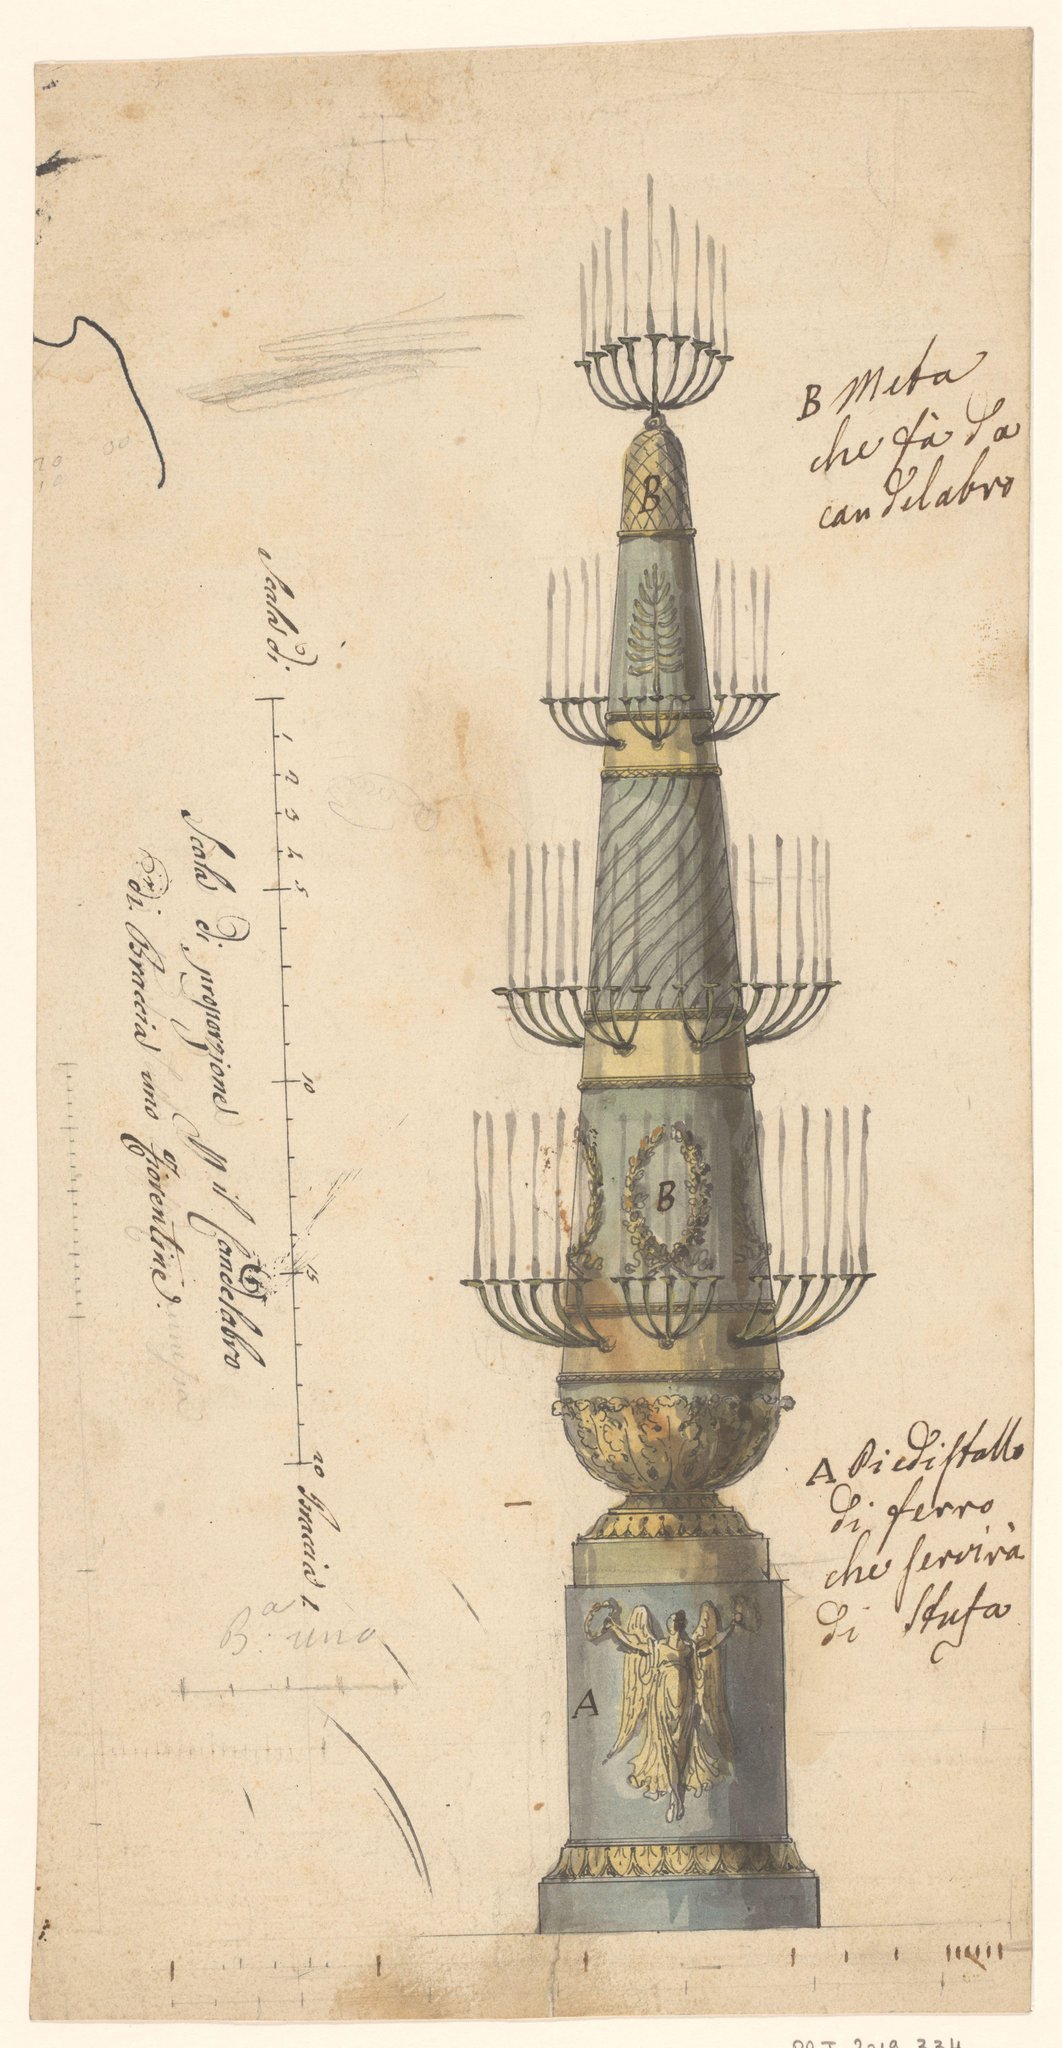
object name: design drawing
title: Ontwerp voor een kandelaber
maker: Anonymous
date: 1800-1810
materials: gouache, graphite, ink, paper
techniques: brush, pen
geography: florence